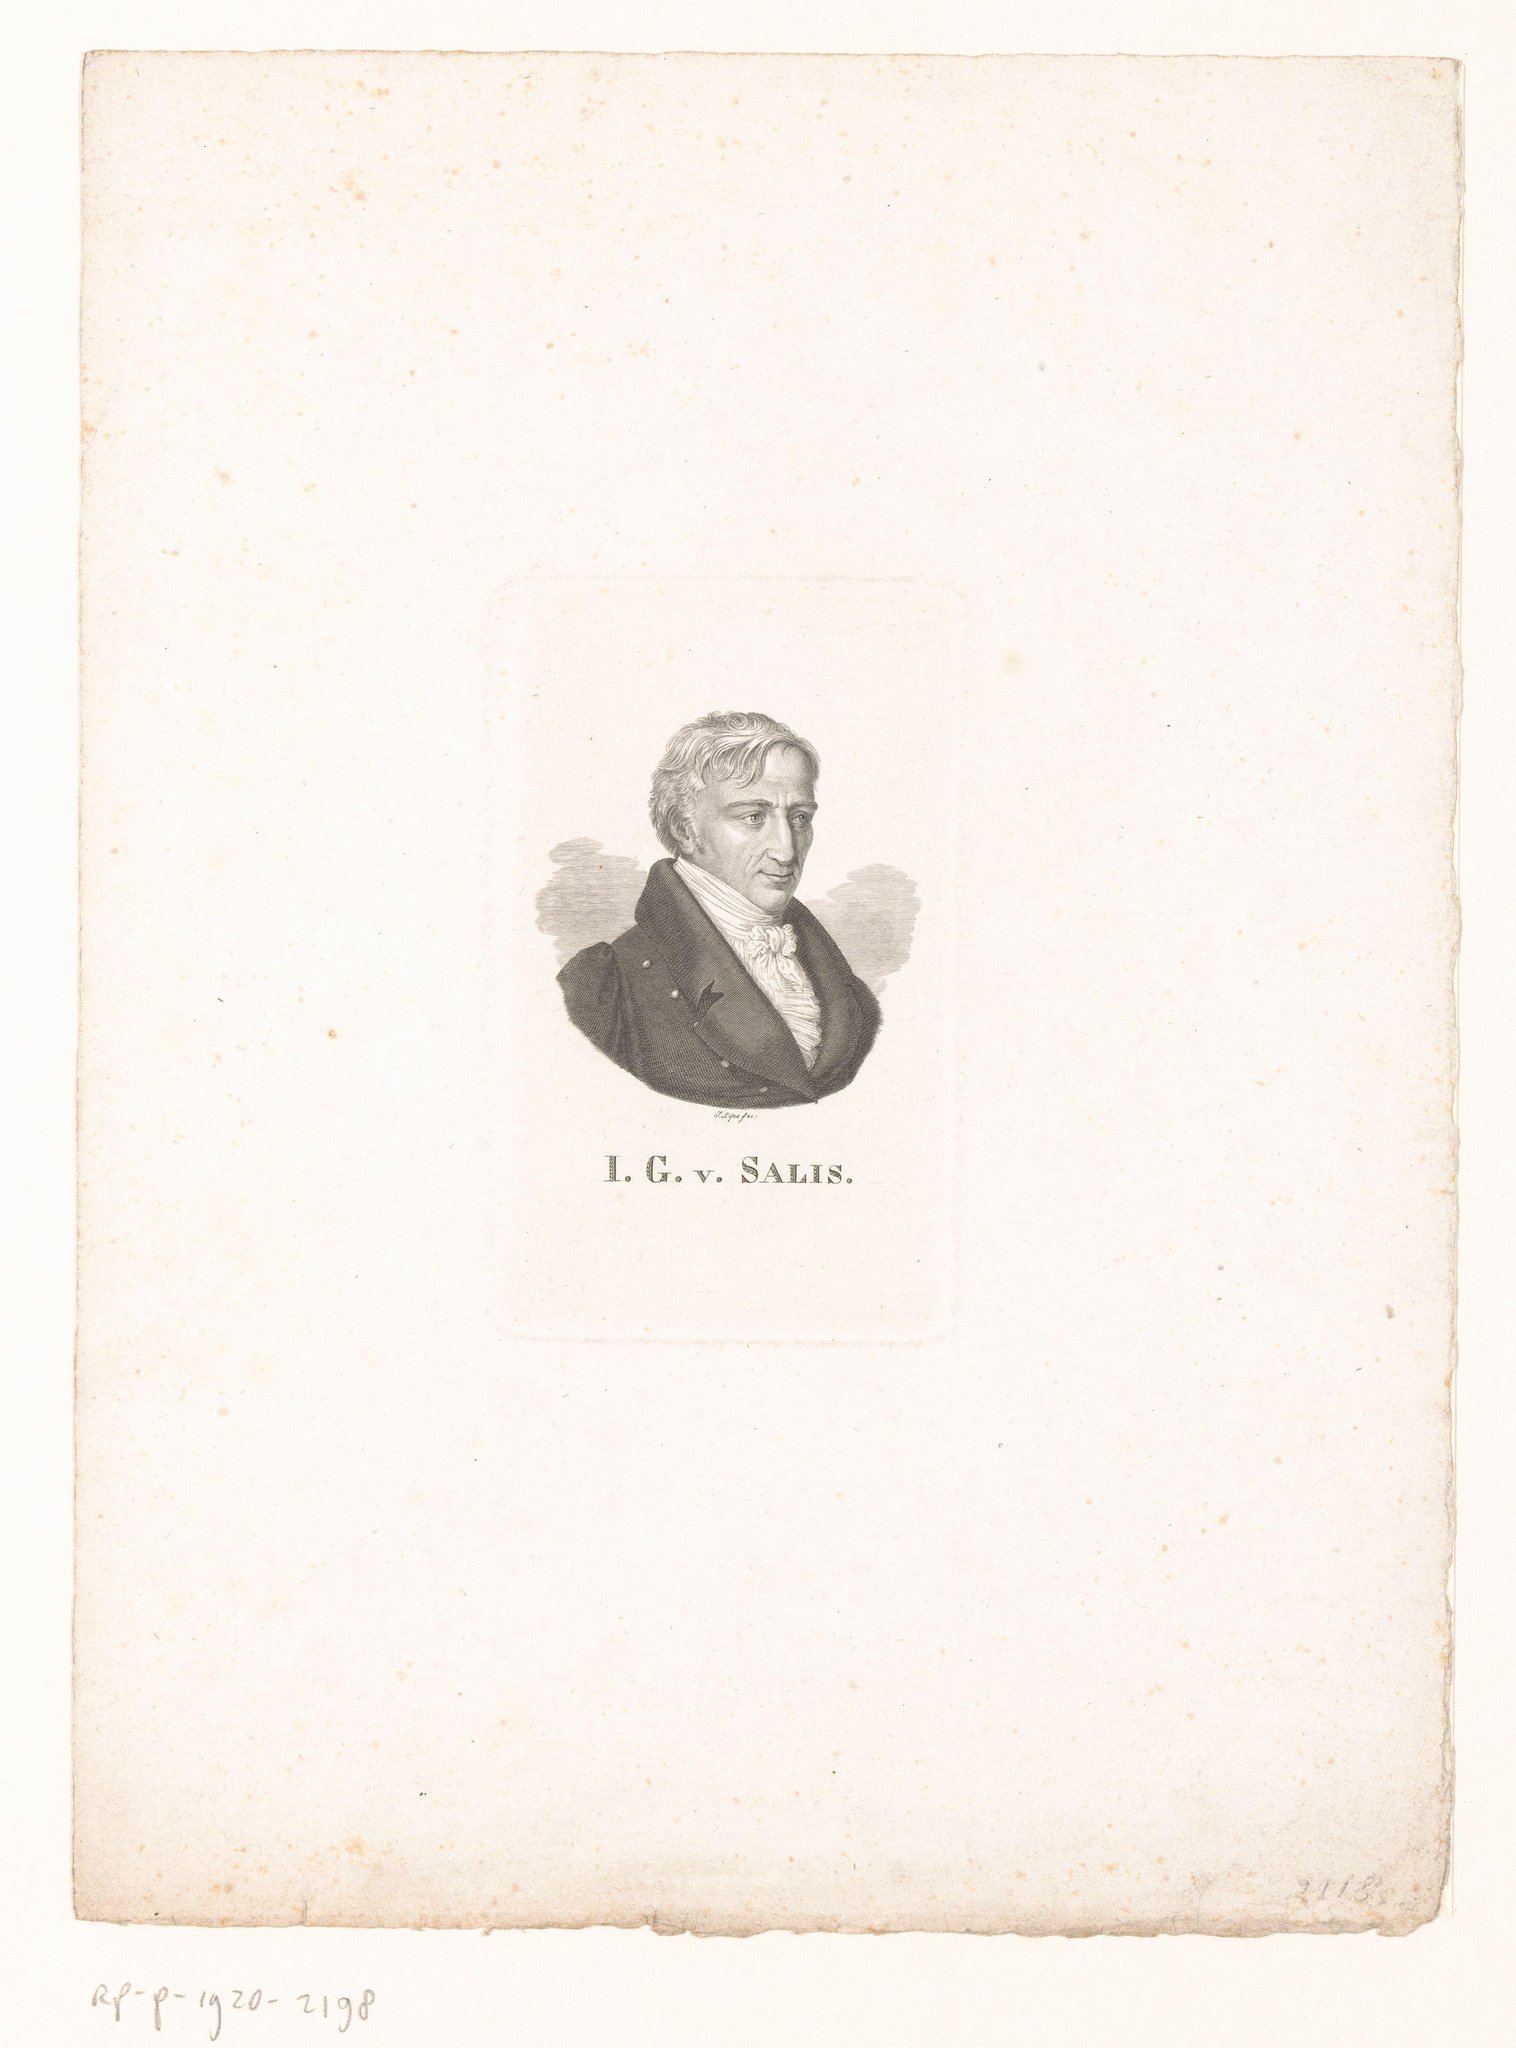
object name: print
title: Portret van Johann Gaudenz, Freiherr von Salis-Seewis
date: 1772-1833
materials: paper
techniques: engraving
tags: historical persons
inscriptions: collector's mark: Lugt 2228